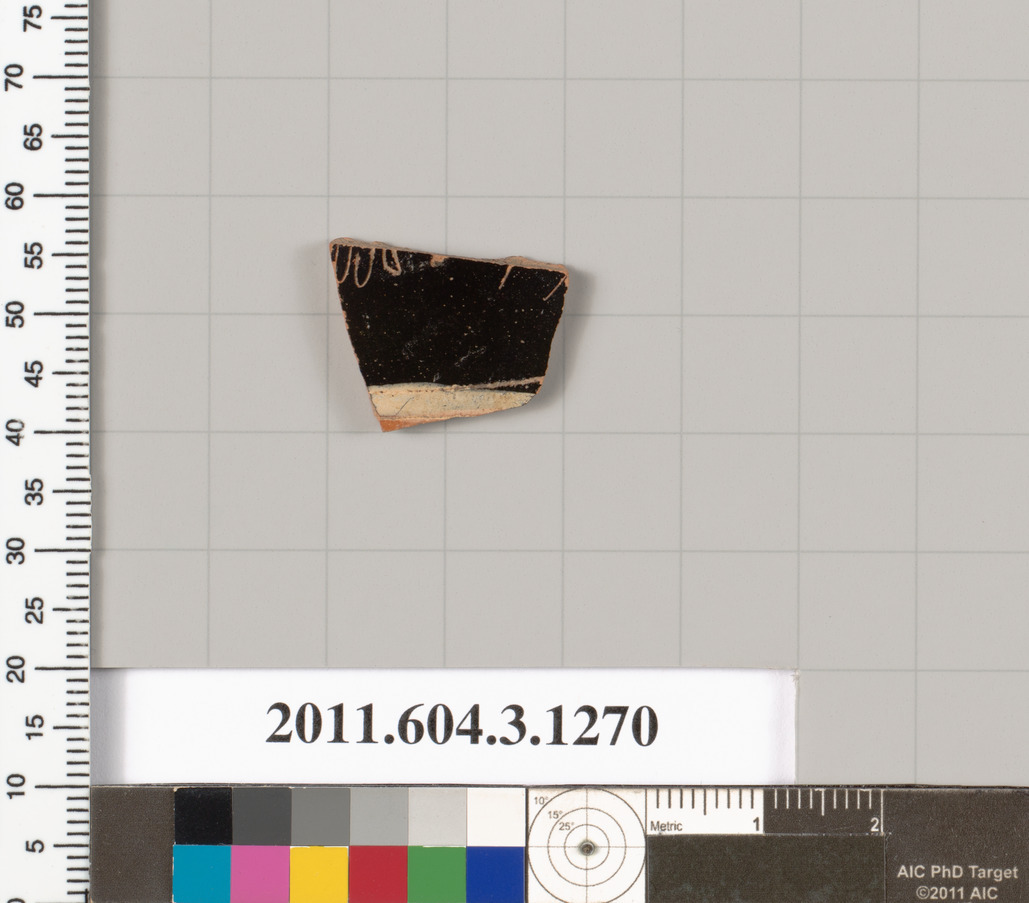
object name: oinochoe fragment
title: Terracotta fragment of an oinochoe (jug)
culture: greek, attic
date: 534-468 BCE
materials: terracotta